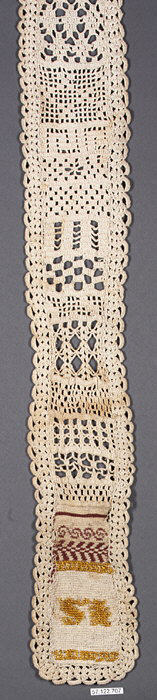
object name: sampler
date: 1801-1900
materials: cotton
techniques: crochet